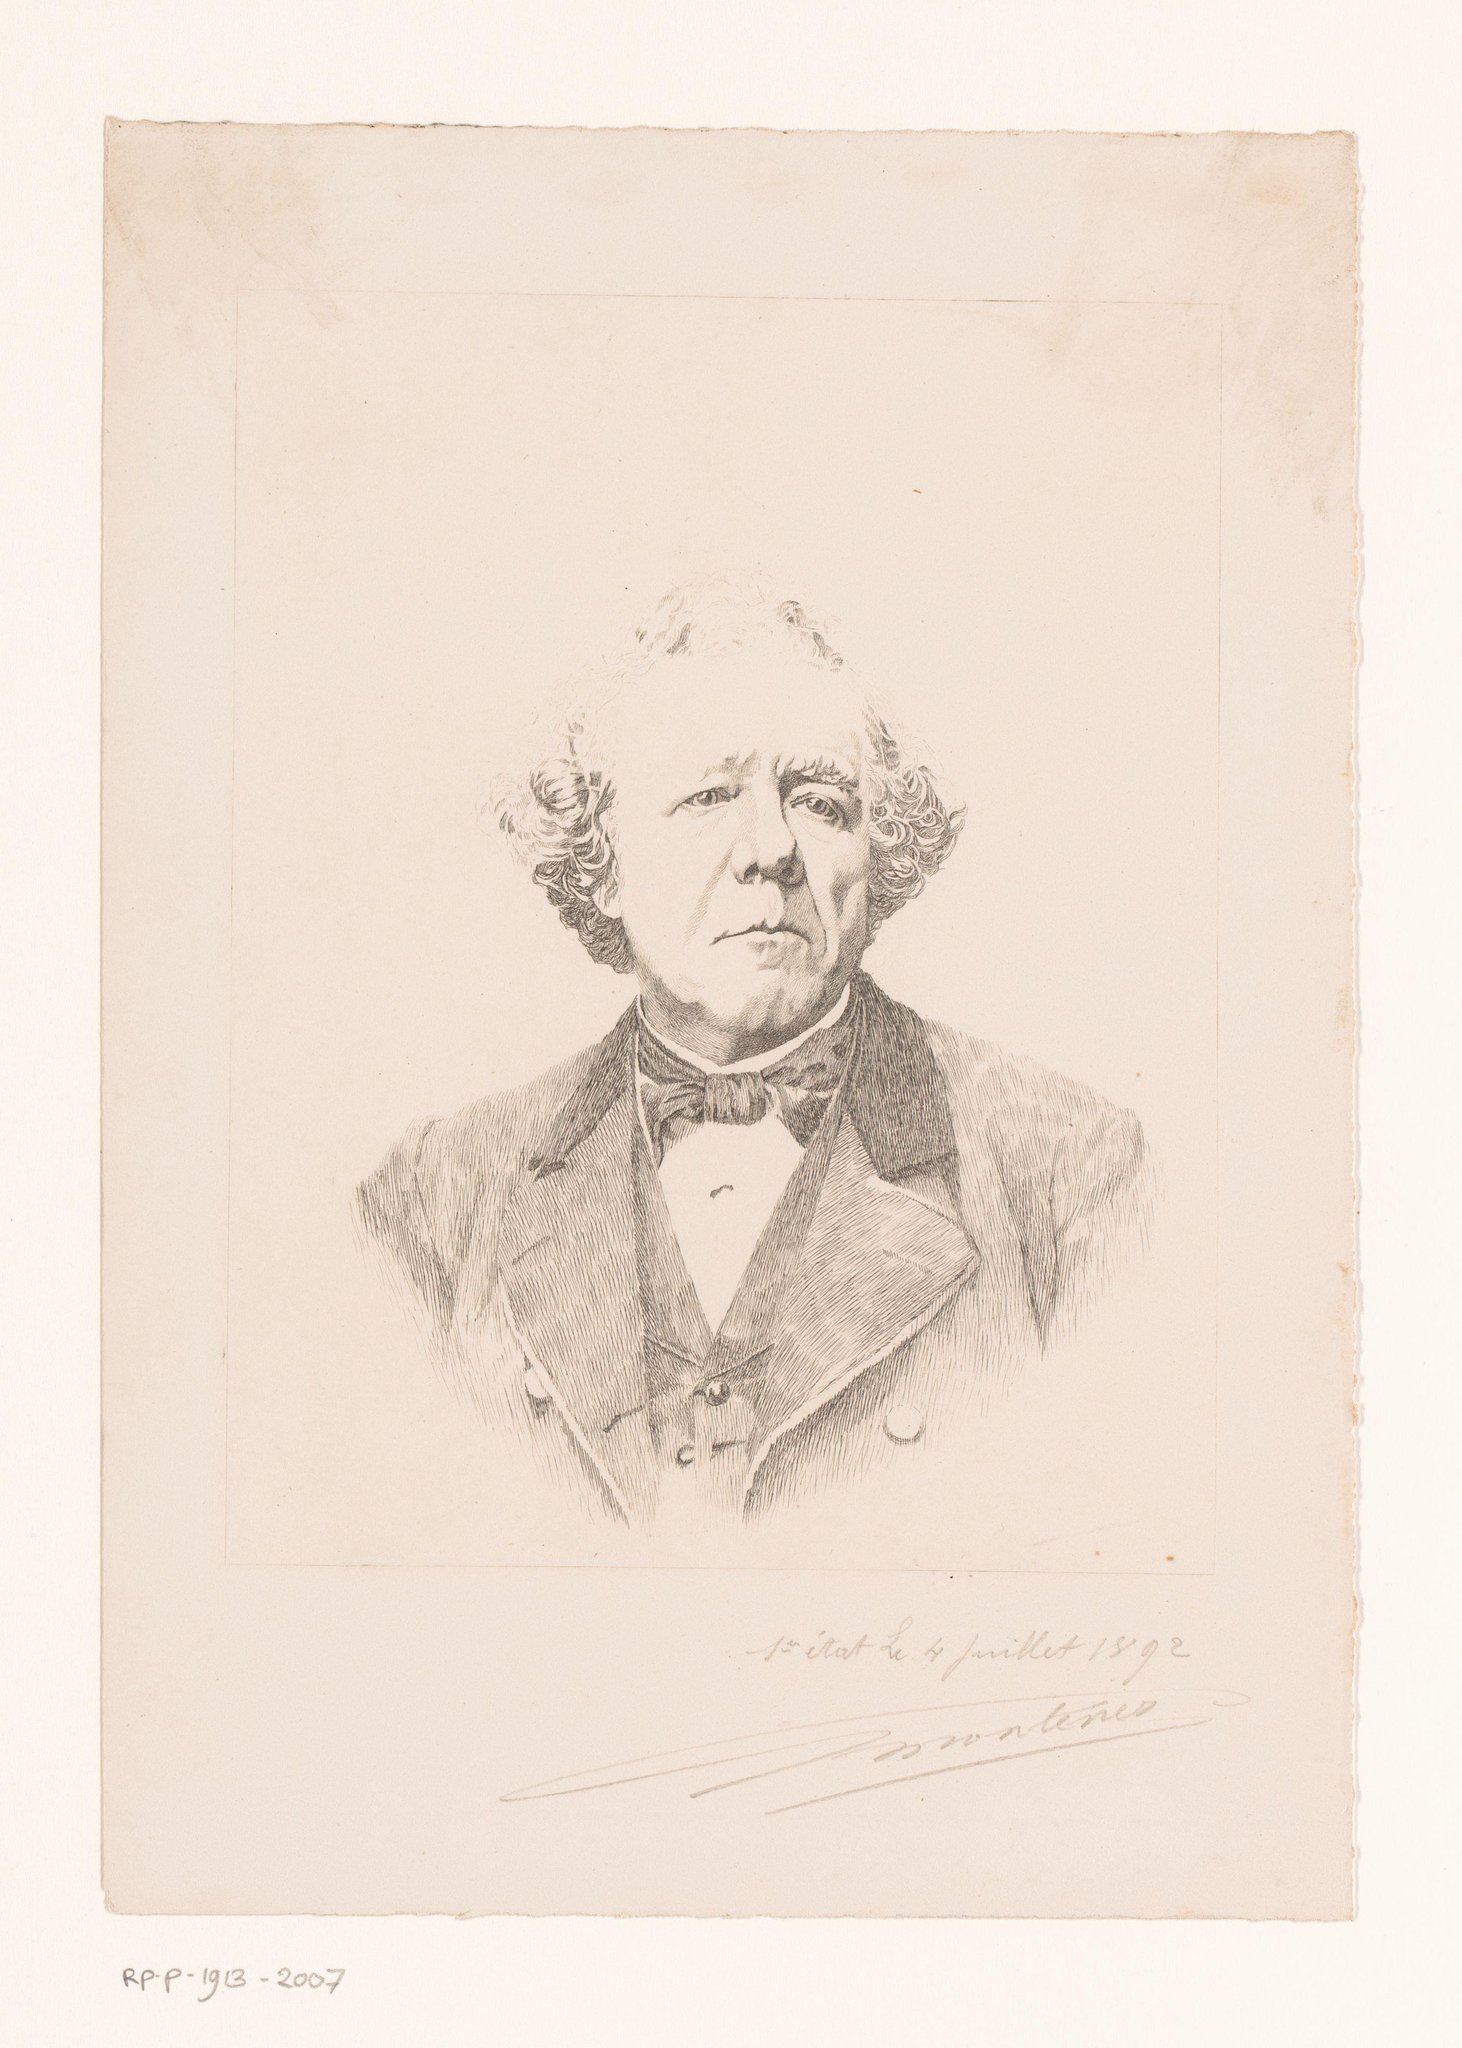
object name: print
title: Portret van een onbekende man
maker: georges montenez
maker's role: print maker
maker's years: 1873-1930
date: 1892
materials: paper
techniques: etching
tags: adult man, historical persons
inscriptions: inscription: ‘1e état le 4 juillet 1892’, collector's mark: Lugt 2228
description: Mogelijk gaat het om een protestantse, Engelse predikant (opschirft in potlood op verso andere staat).